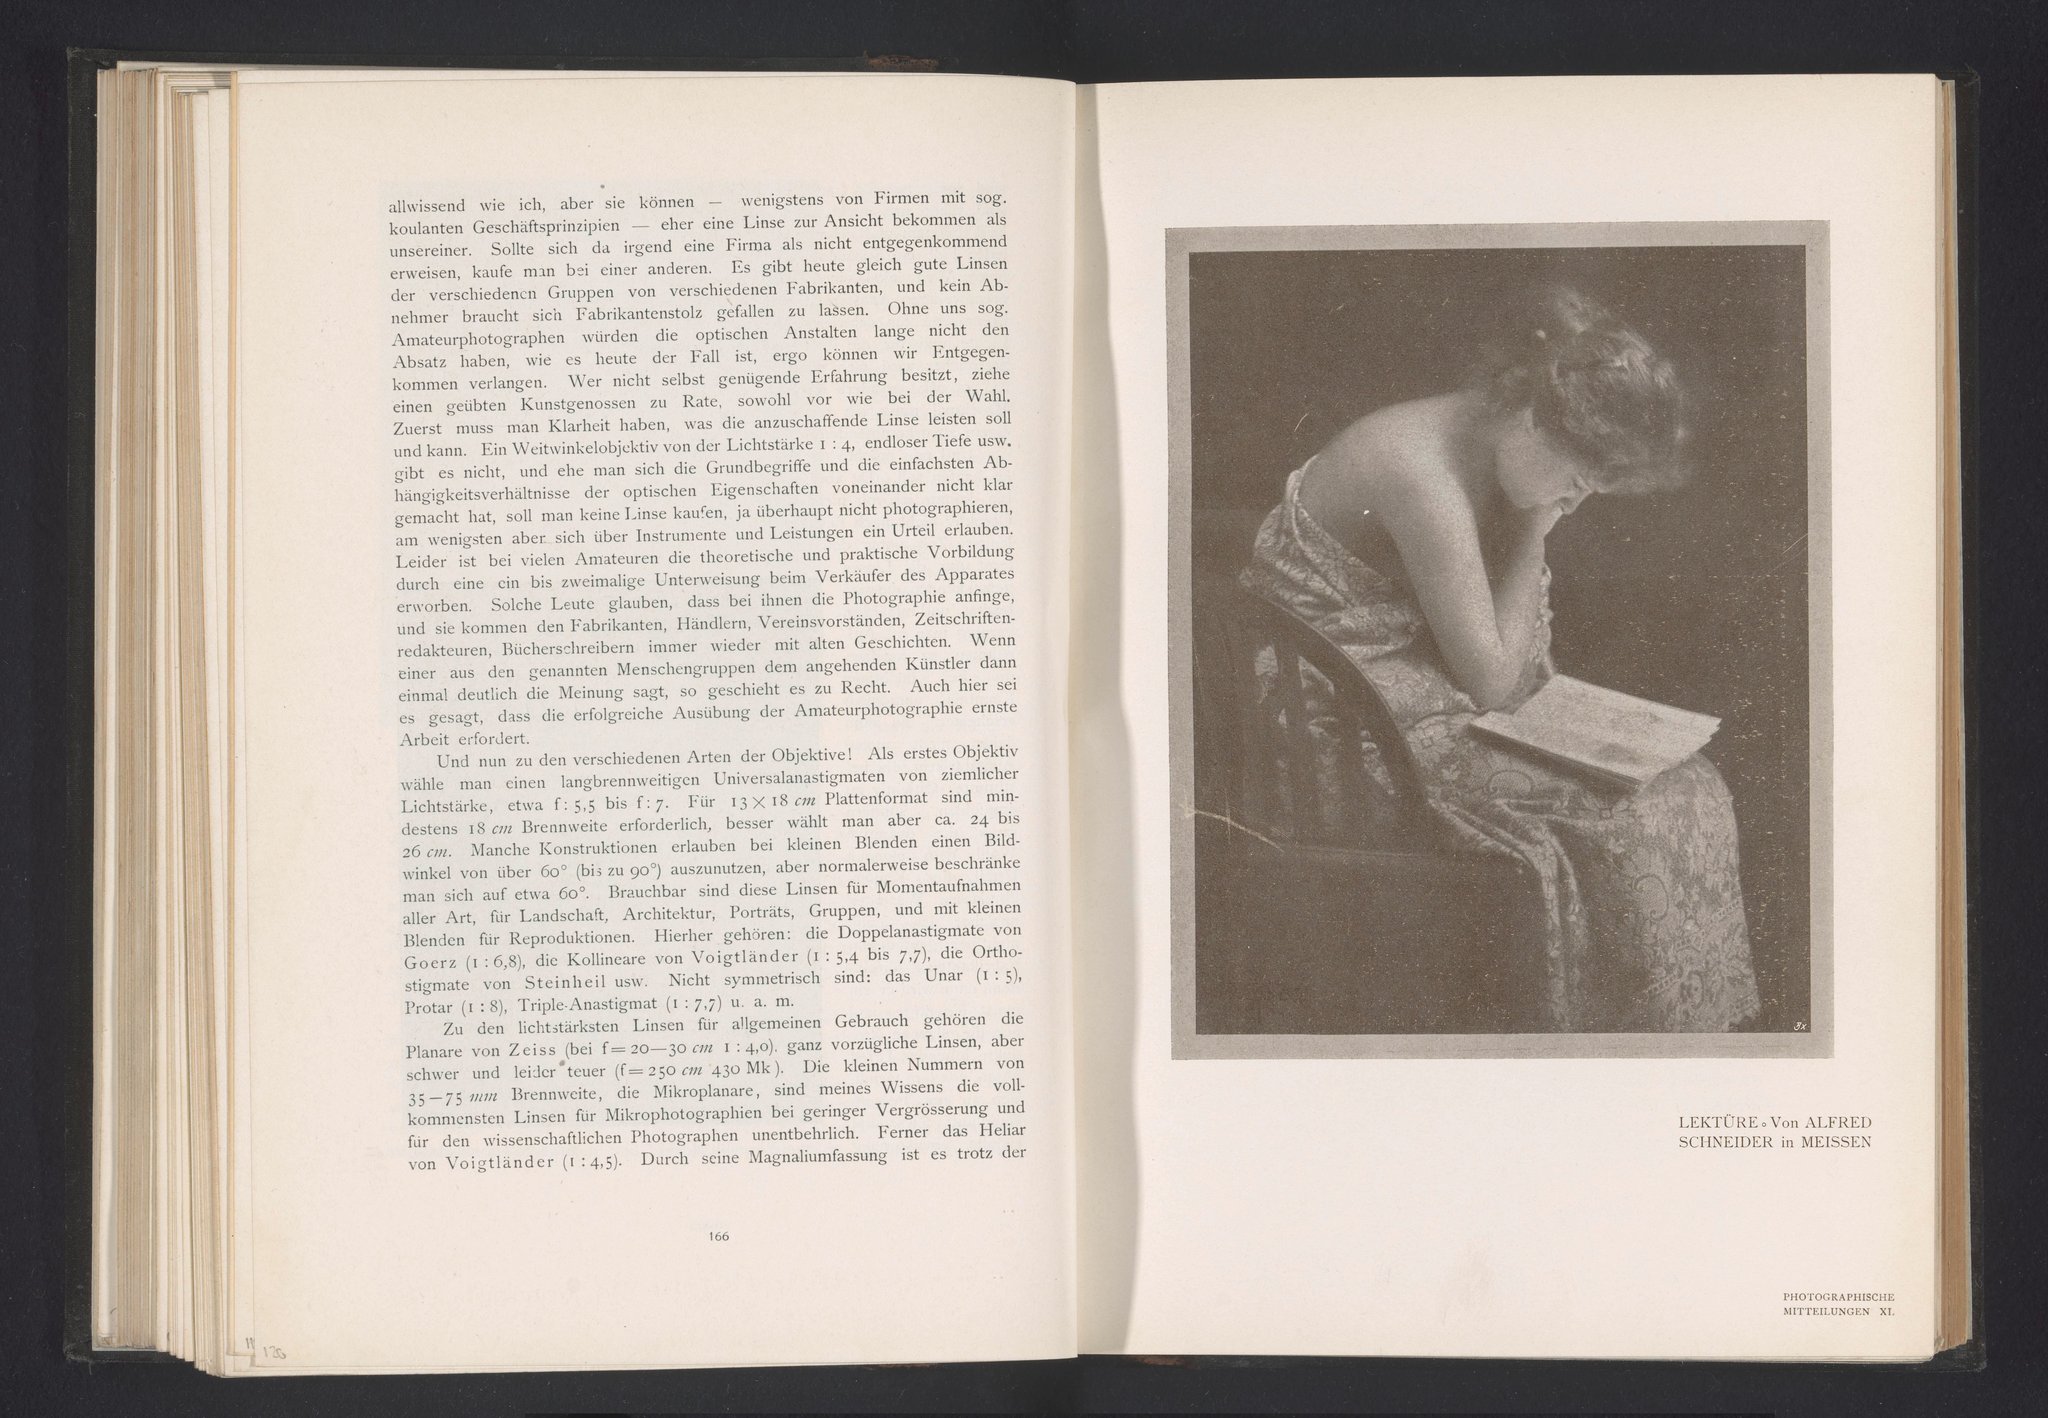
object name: photomechanical print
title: Portret van een onbekende vrouw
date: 1898-1903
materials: paper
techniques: autotype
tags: historical persons - bb - woman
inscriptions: monogram: ‘BX’, inscription: ‘Photographische Mitteilungen XL’